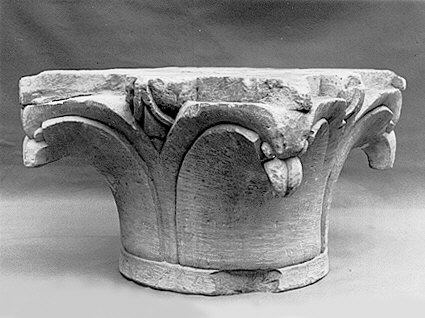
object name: capital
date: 501-700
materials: limestone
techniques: carving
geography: egypt